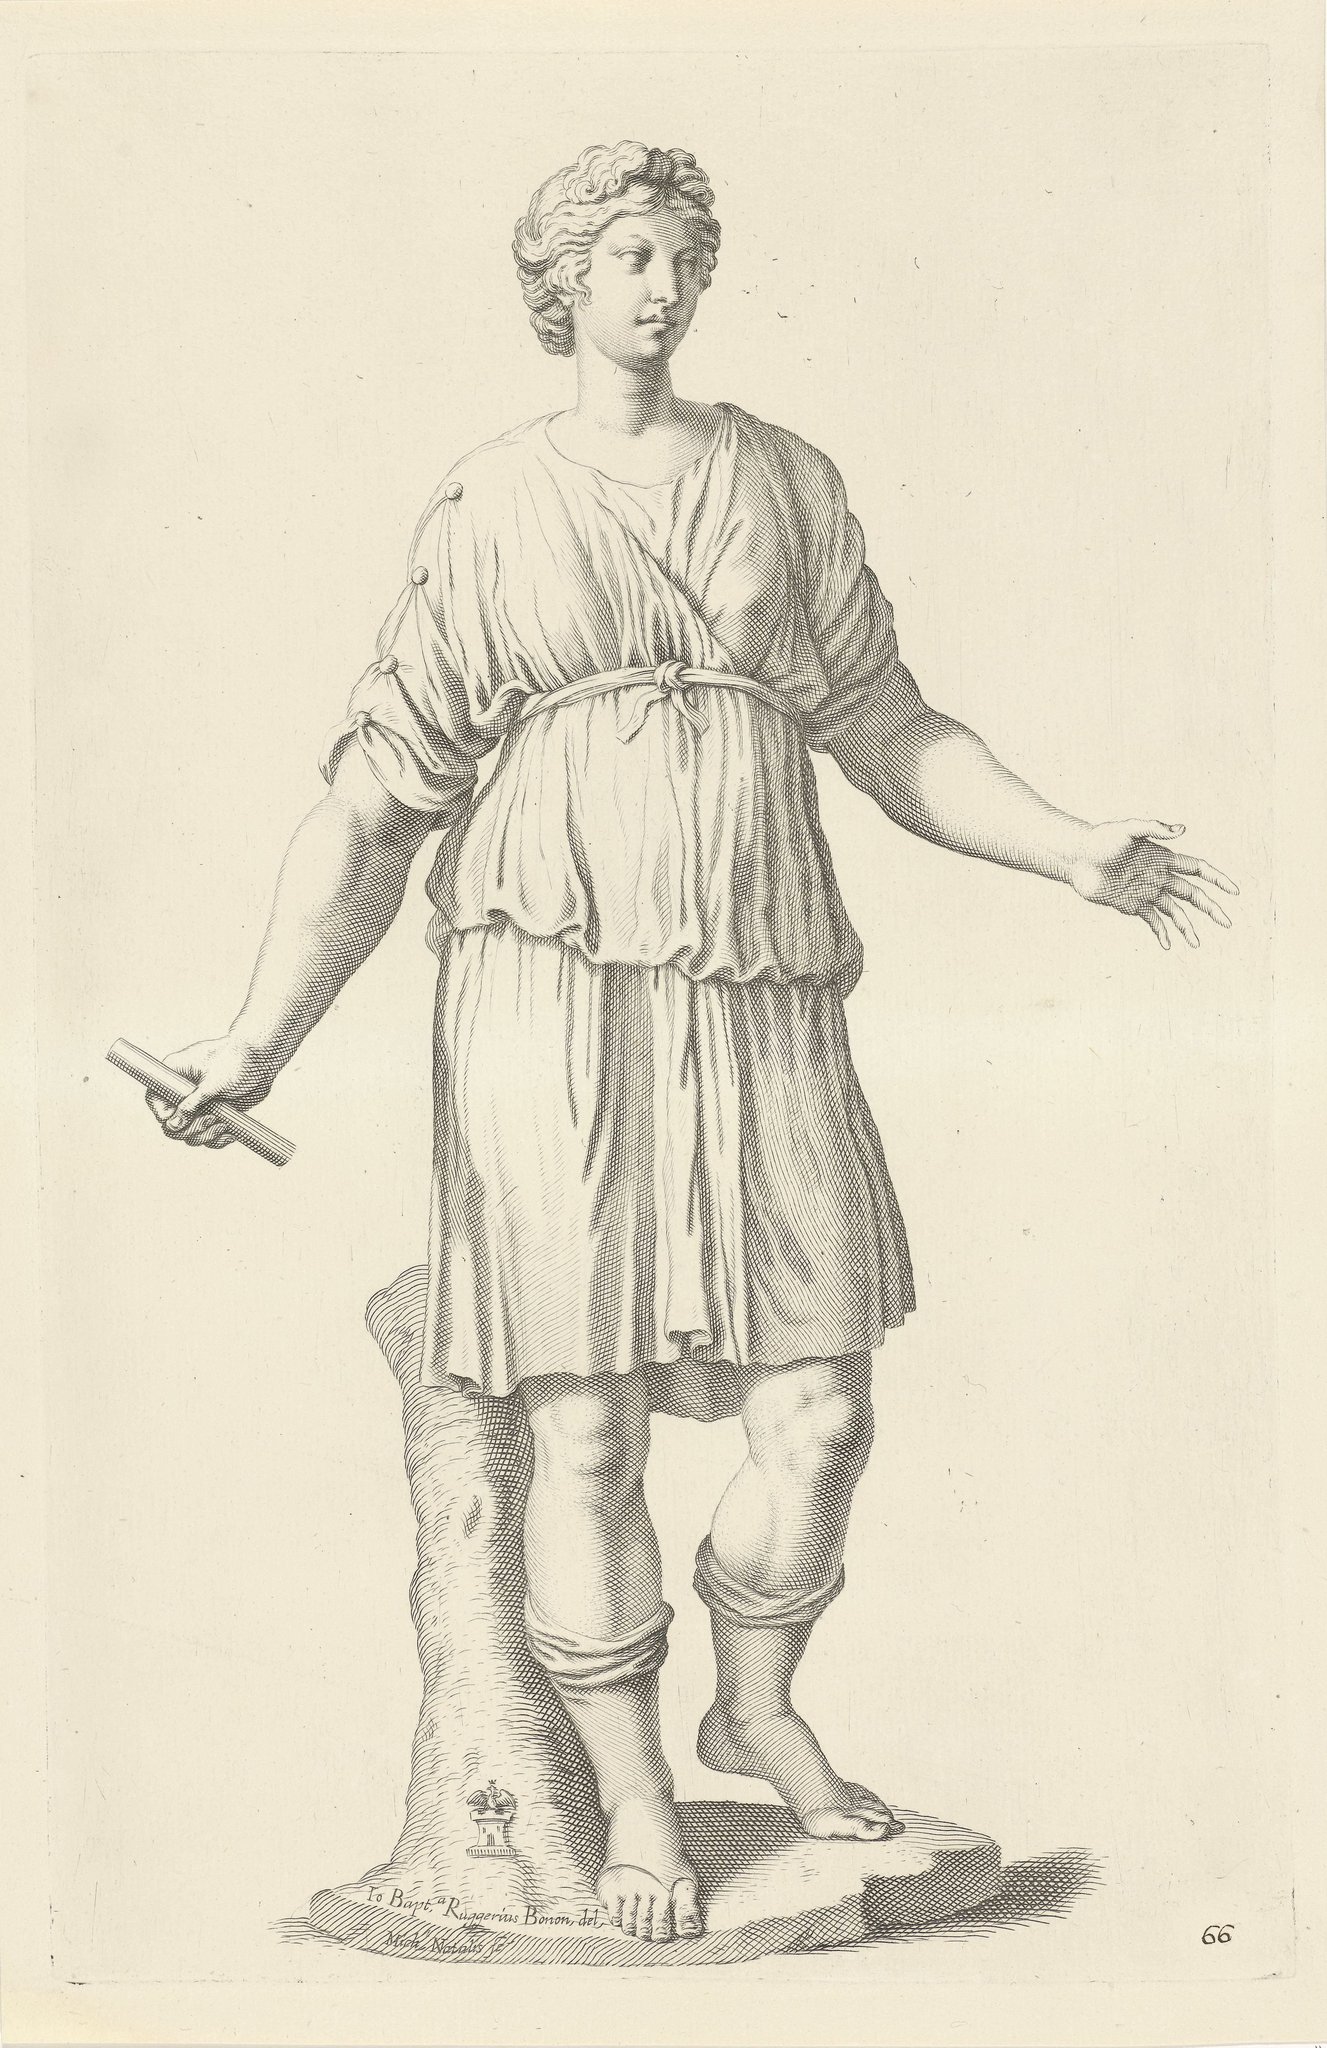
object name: print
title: Standbeeld van staande vrouw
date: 1640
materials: paper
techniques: engraving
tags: rome, vincenzo giustiniani (1564-1637), piece of sculpture, reproduction of a piece of sculpture, monument, statue, female persons from classical history (+ full length)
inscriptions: collector's mark: Lugt 2228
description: Standbeeld van een staande vrouw, gekleed in een klassiek gewaad tot op de knie, bij een boomstam. In haar rechterhand houdt zij een stok. Op de boomstam het wapenschild van Vincenzo Giustiniani. Prent uit een serie naar de sculpturen in de verzameling in de Galleria Giustiniani te Rome.